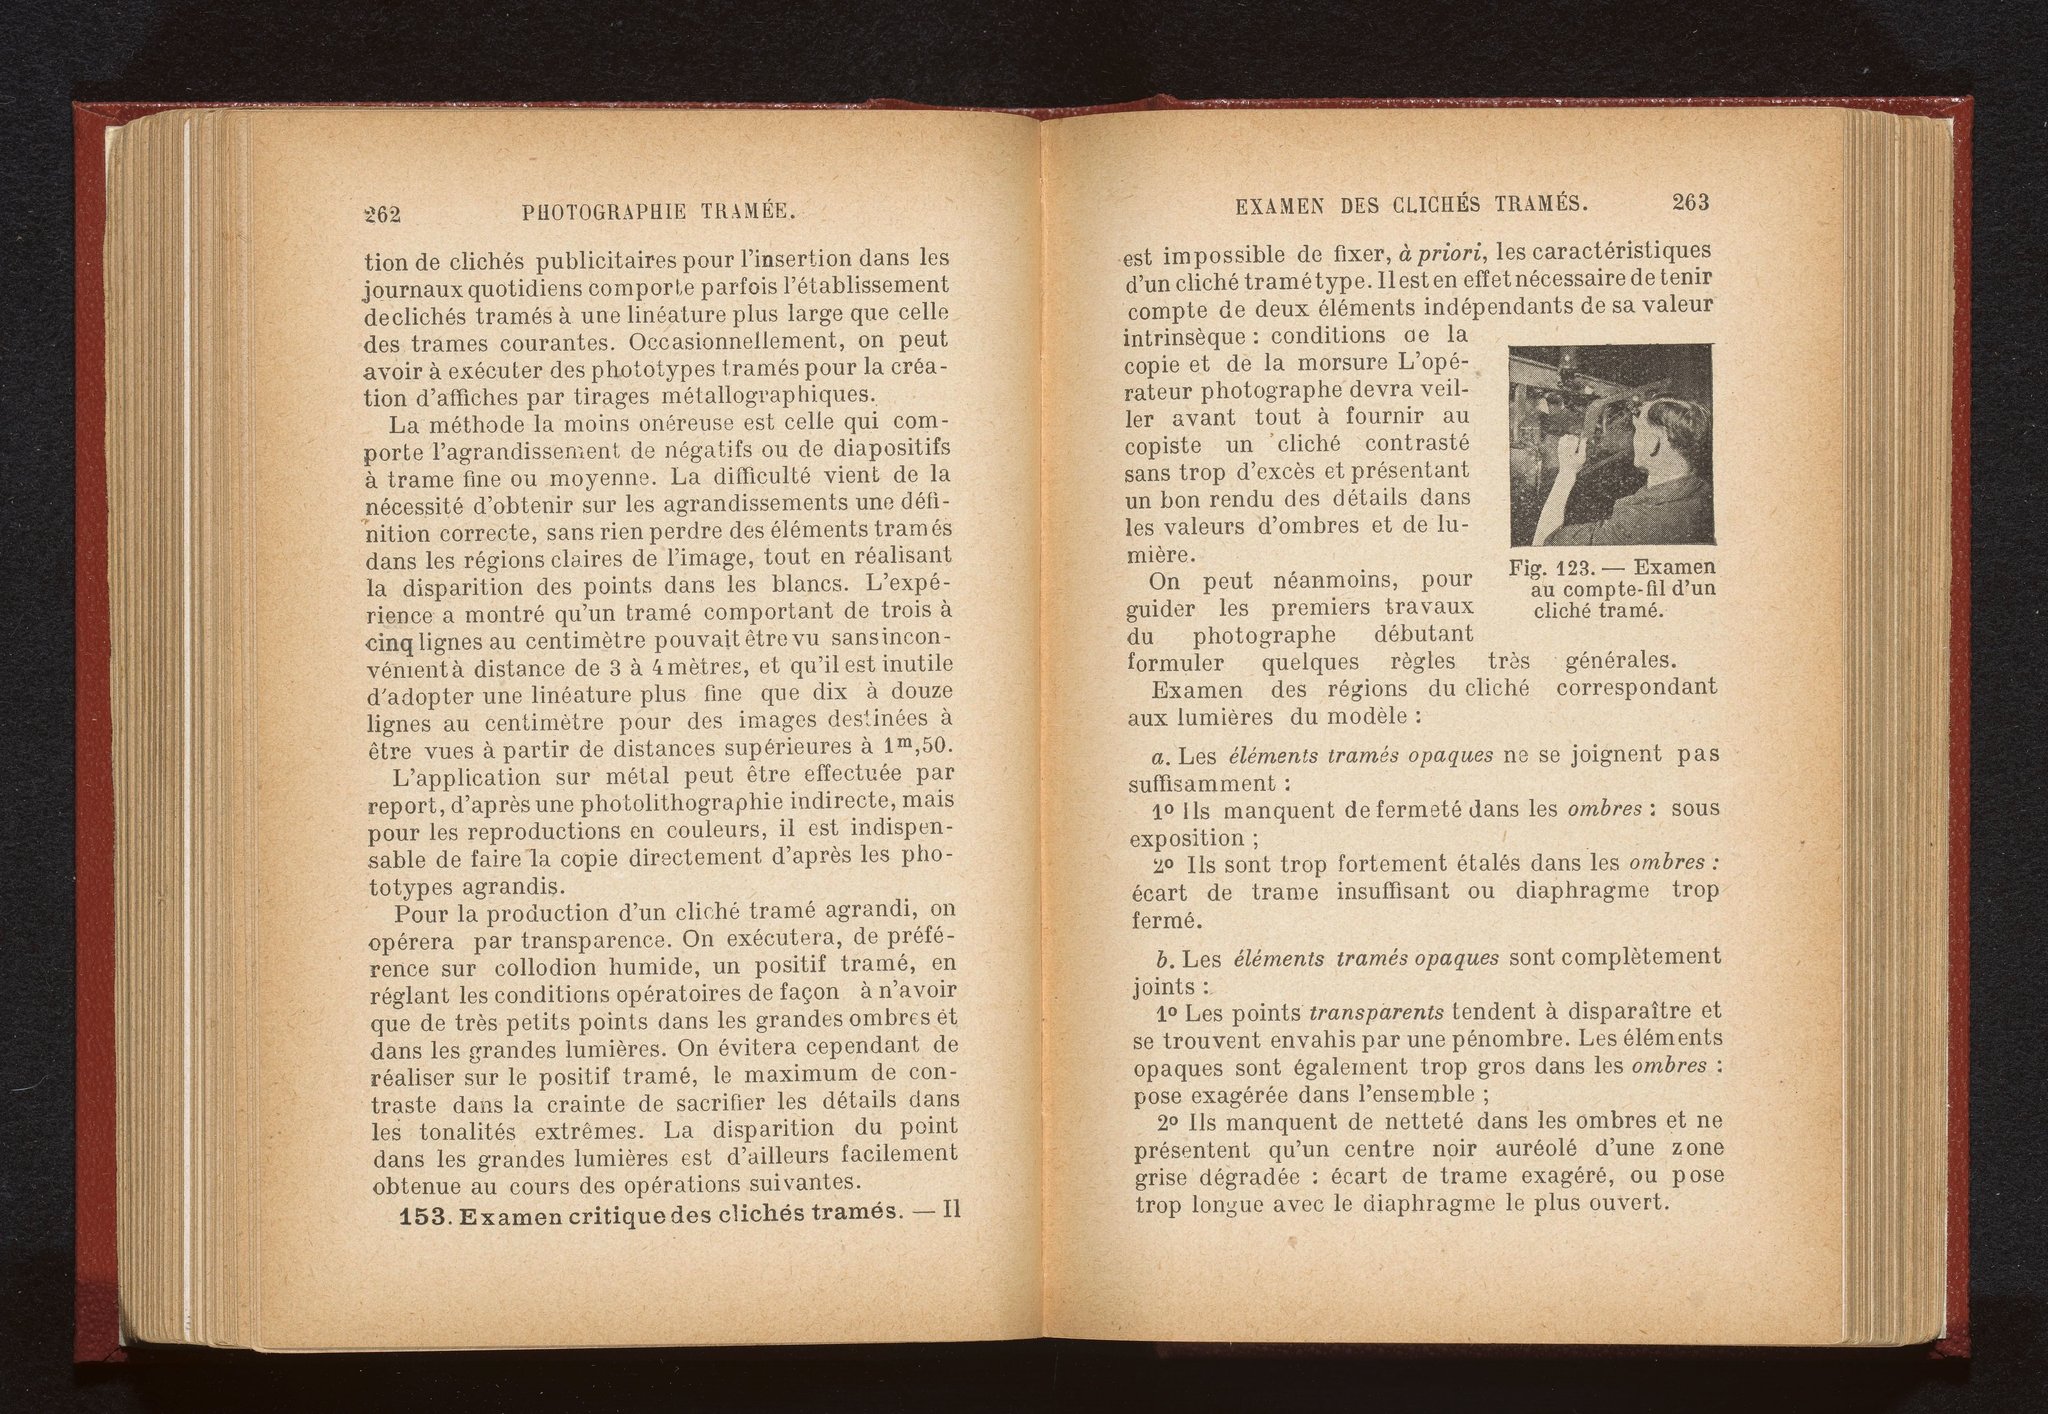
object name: photomechanical print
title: Examen au compte-fil d'un cliché tramé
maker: Anonymous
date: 1922-1932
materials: paper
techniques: autotype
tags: photographic apparatus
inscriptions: number: ‘Fig. 123.’